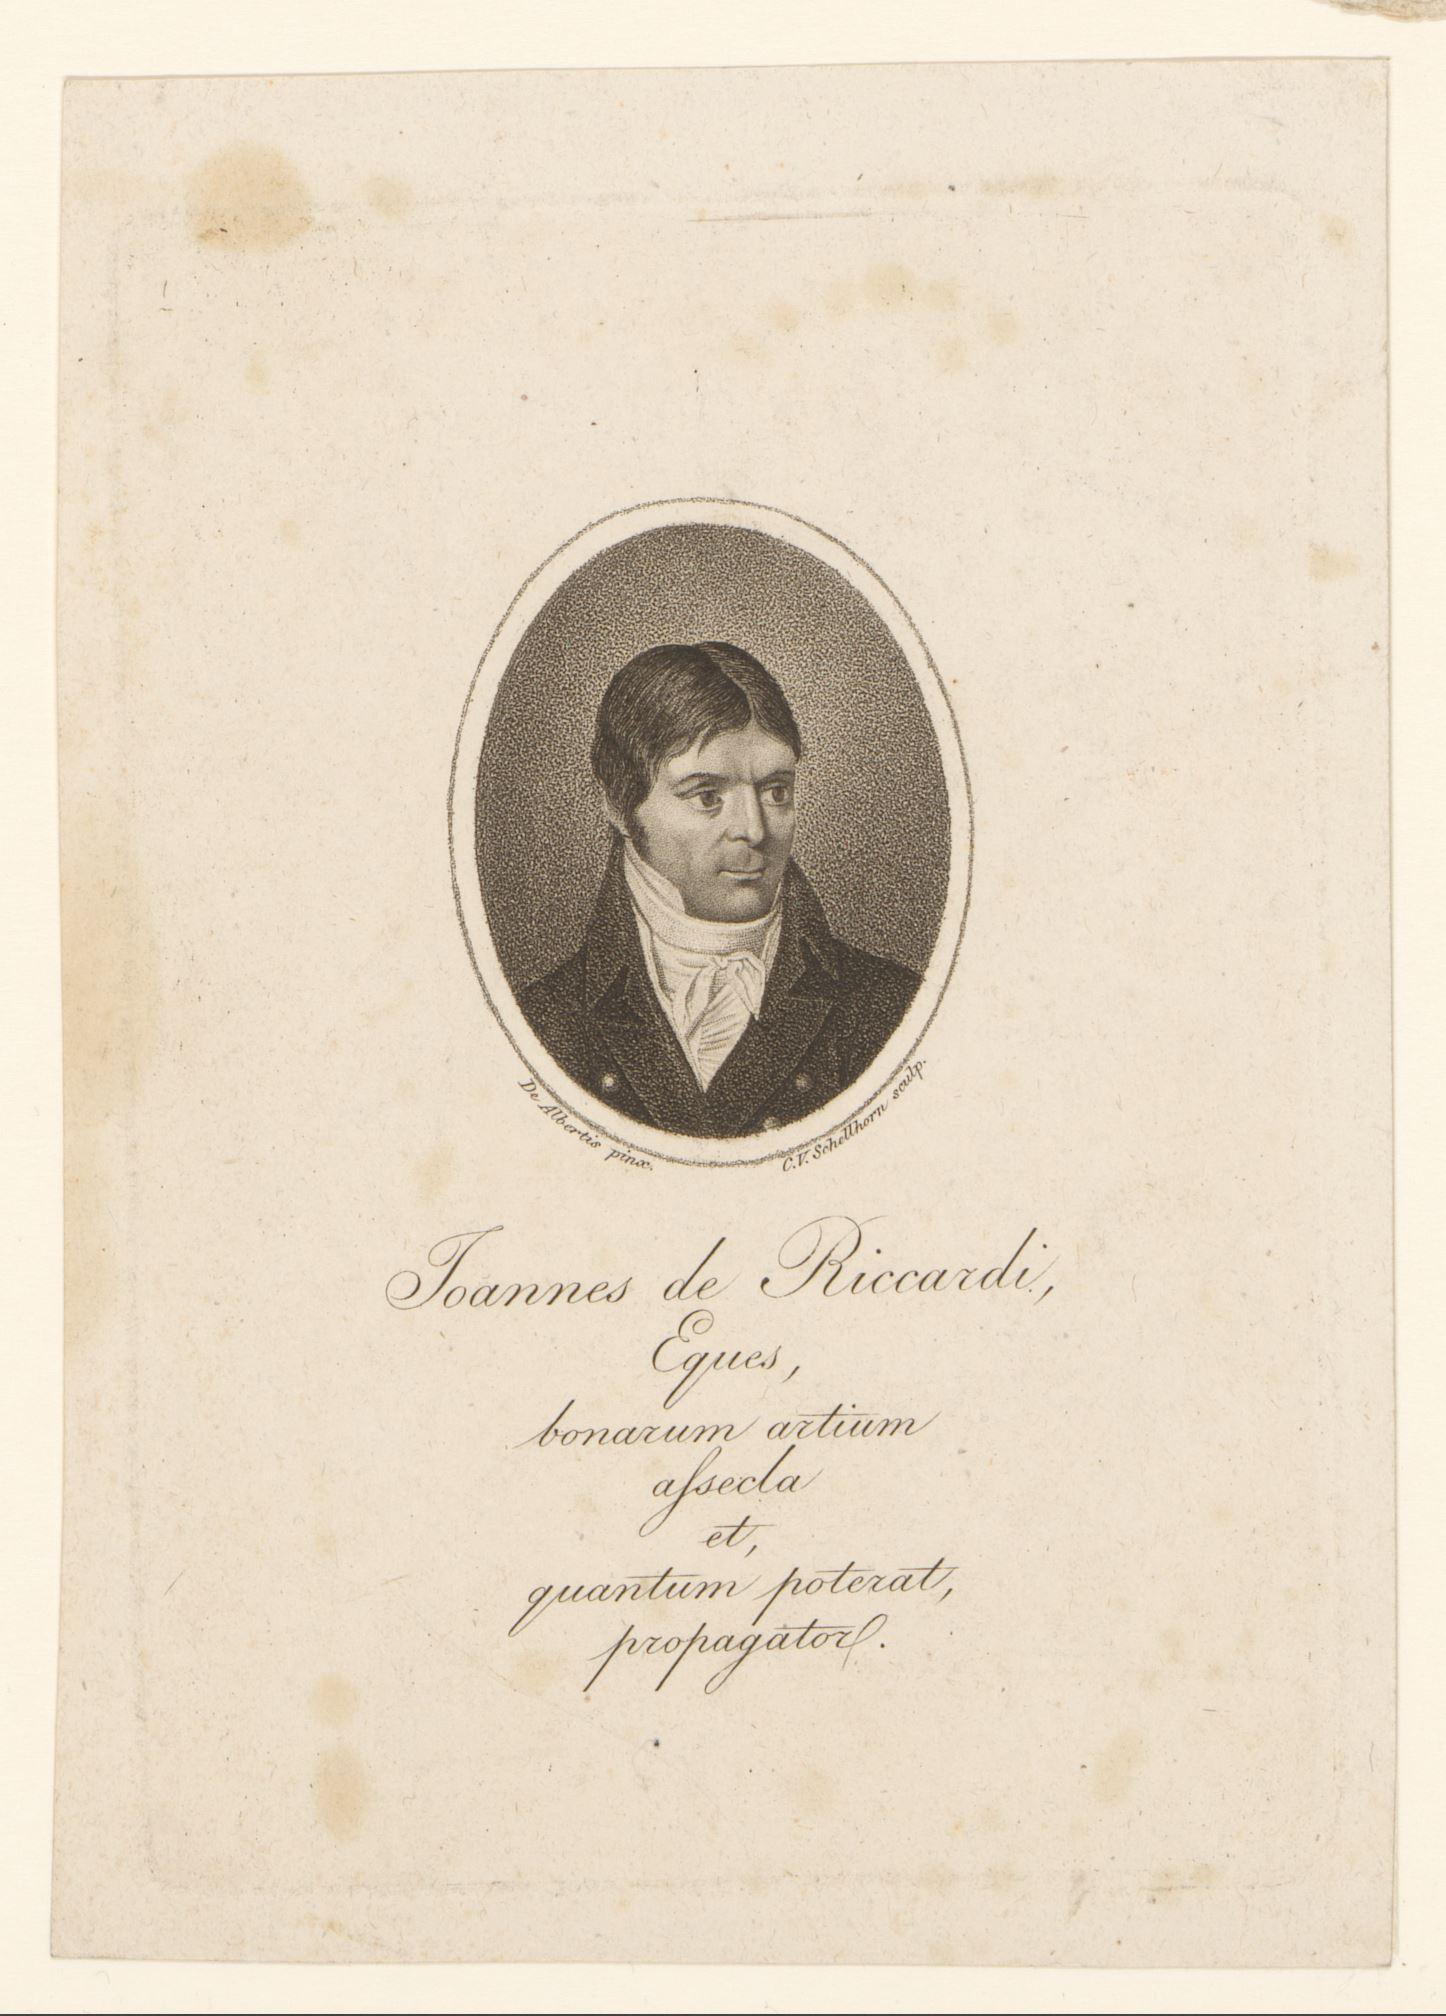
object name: print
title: Portret van Joannes de Riccardi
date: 1810-1850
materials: paper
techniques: engraving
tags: historical persons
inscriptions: collector's mark: Lugt 2228